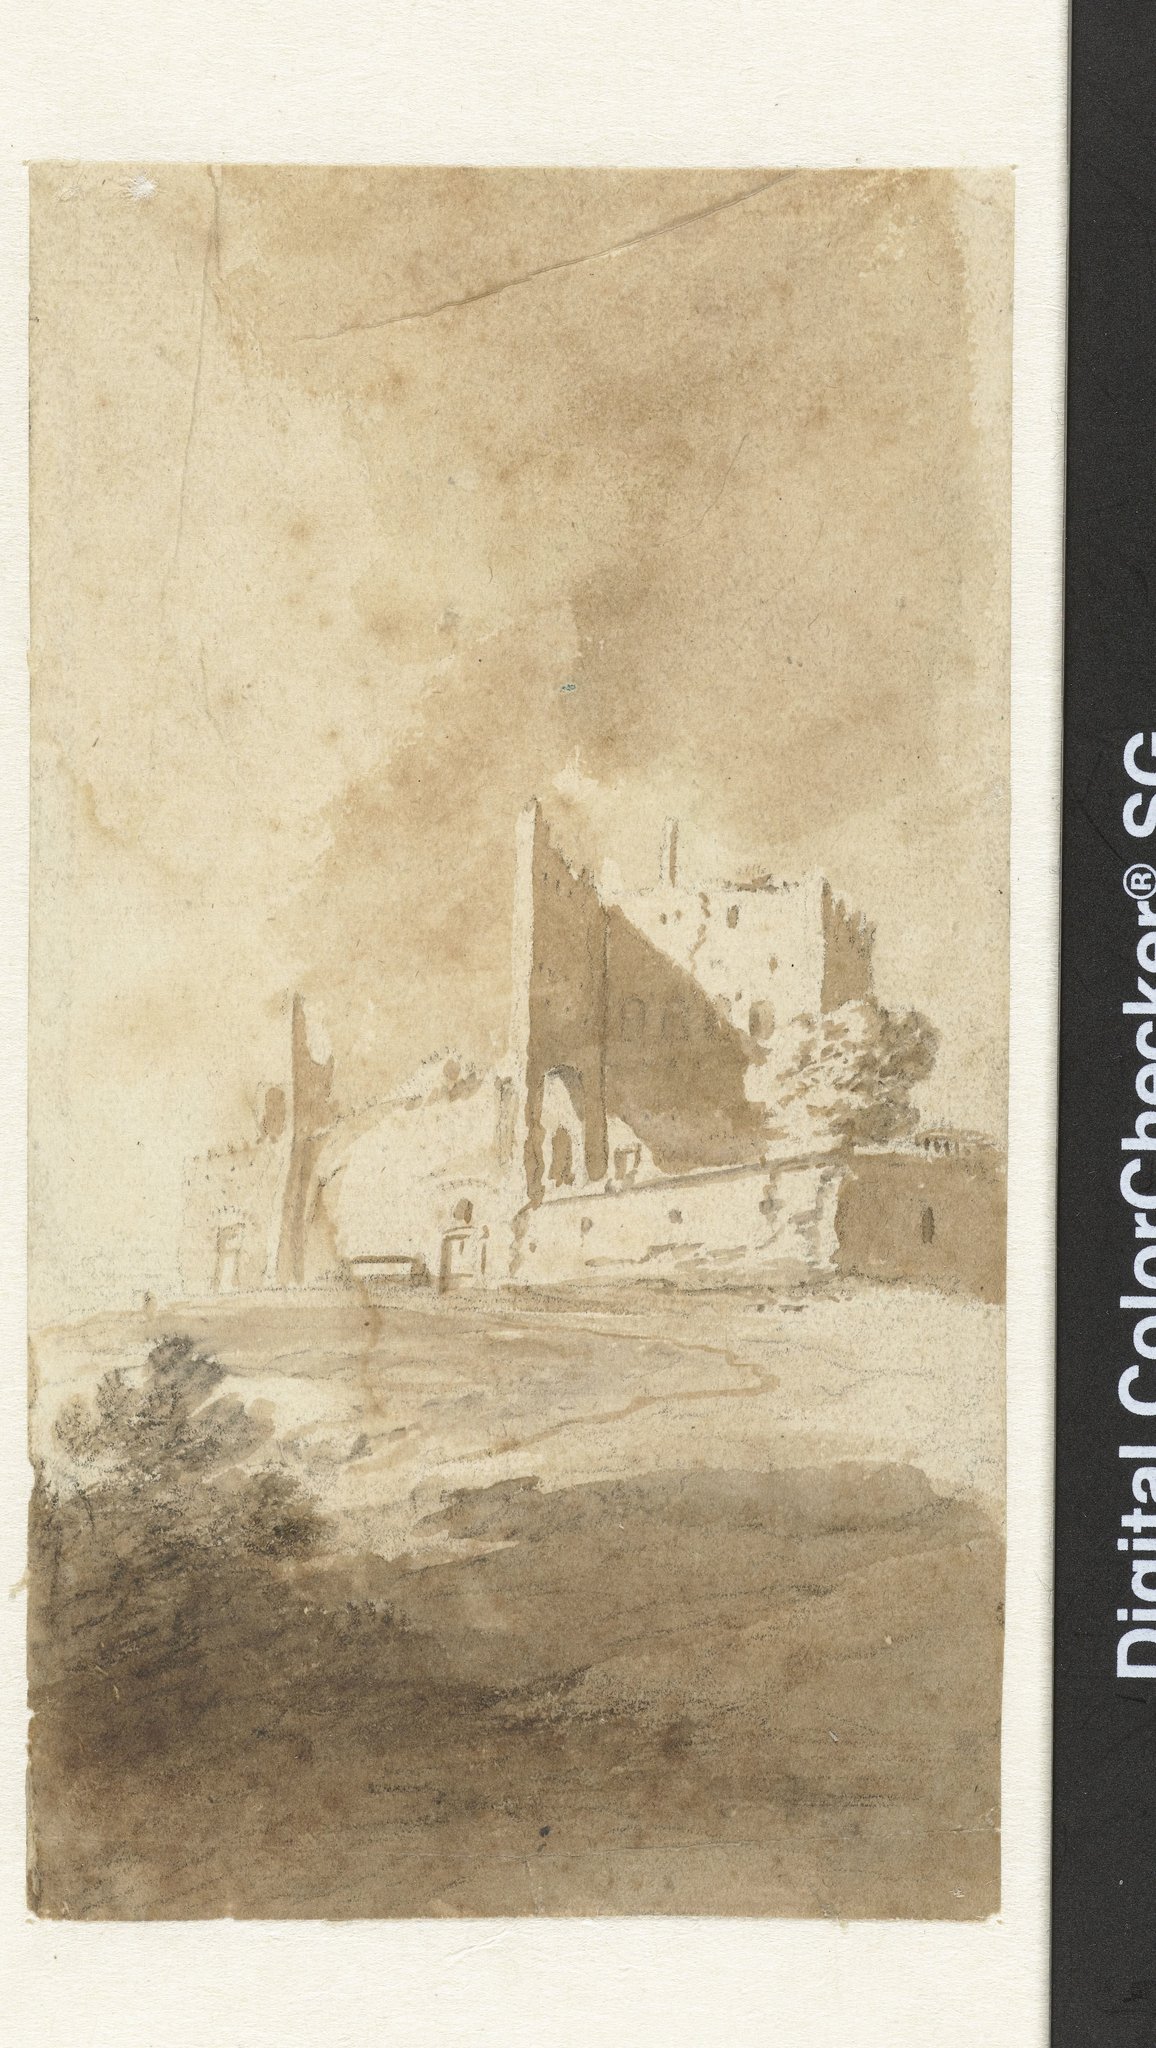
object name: drawing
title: Gezicht op een ruïne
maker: bartholomeus breenbergh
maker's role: draughtsman, print maker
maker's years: 1599-1657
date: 1624-1629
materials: graphite, paper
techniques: brush